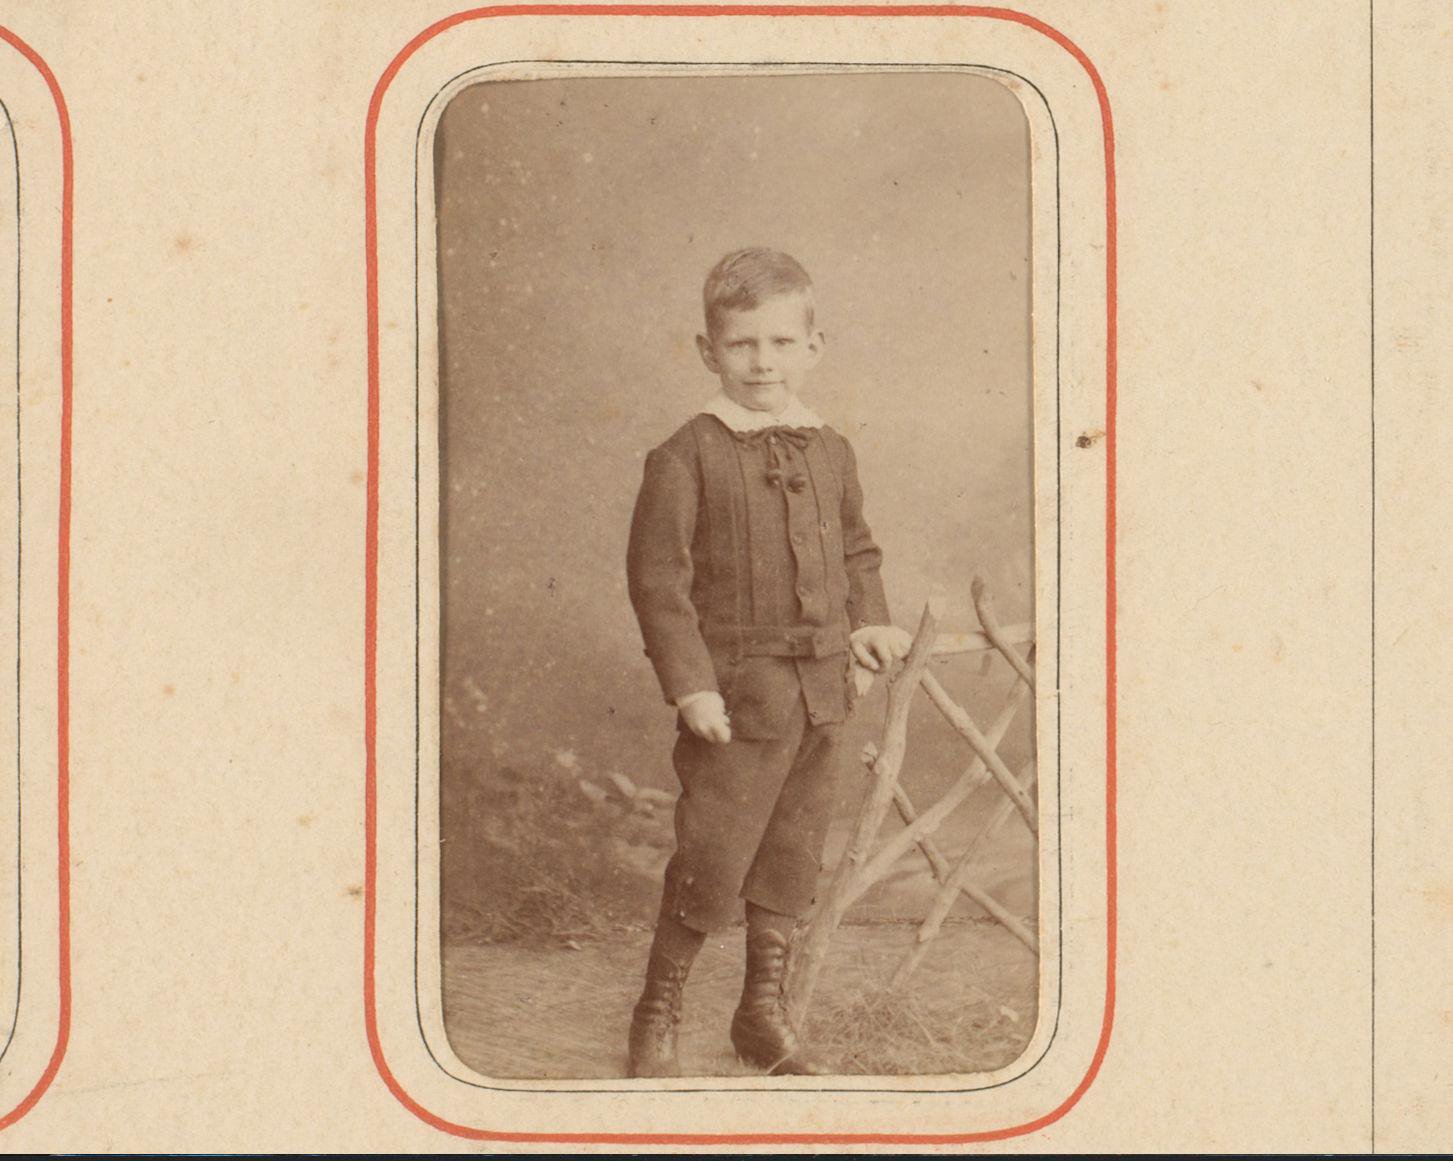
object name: carte de visite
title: Portret van een onbekend kind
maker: bernardus bruining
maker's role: fotograaf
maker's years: 1834-1900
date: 1880-1890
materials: cardboard, paper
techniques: albumen print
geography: arnhem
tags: anonymous historical person portrayed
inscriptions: address: ‘Steenstraat/ Arnhem.’